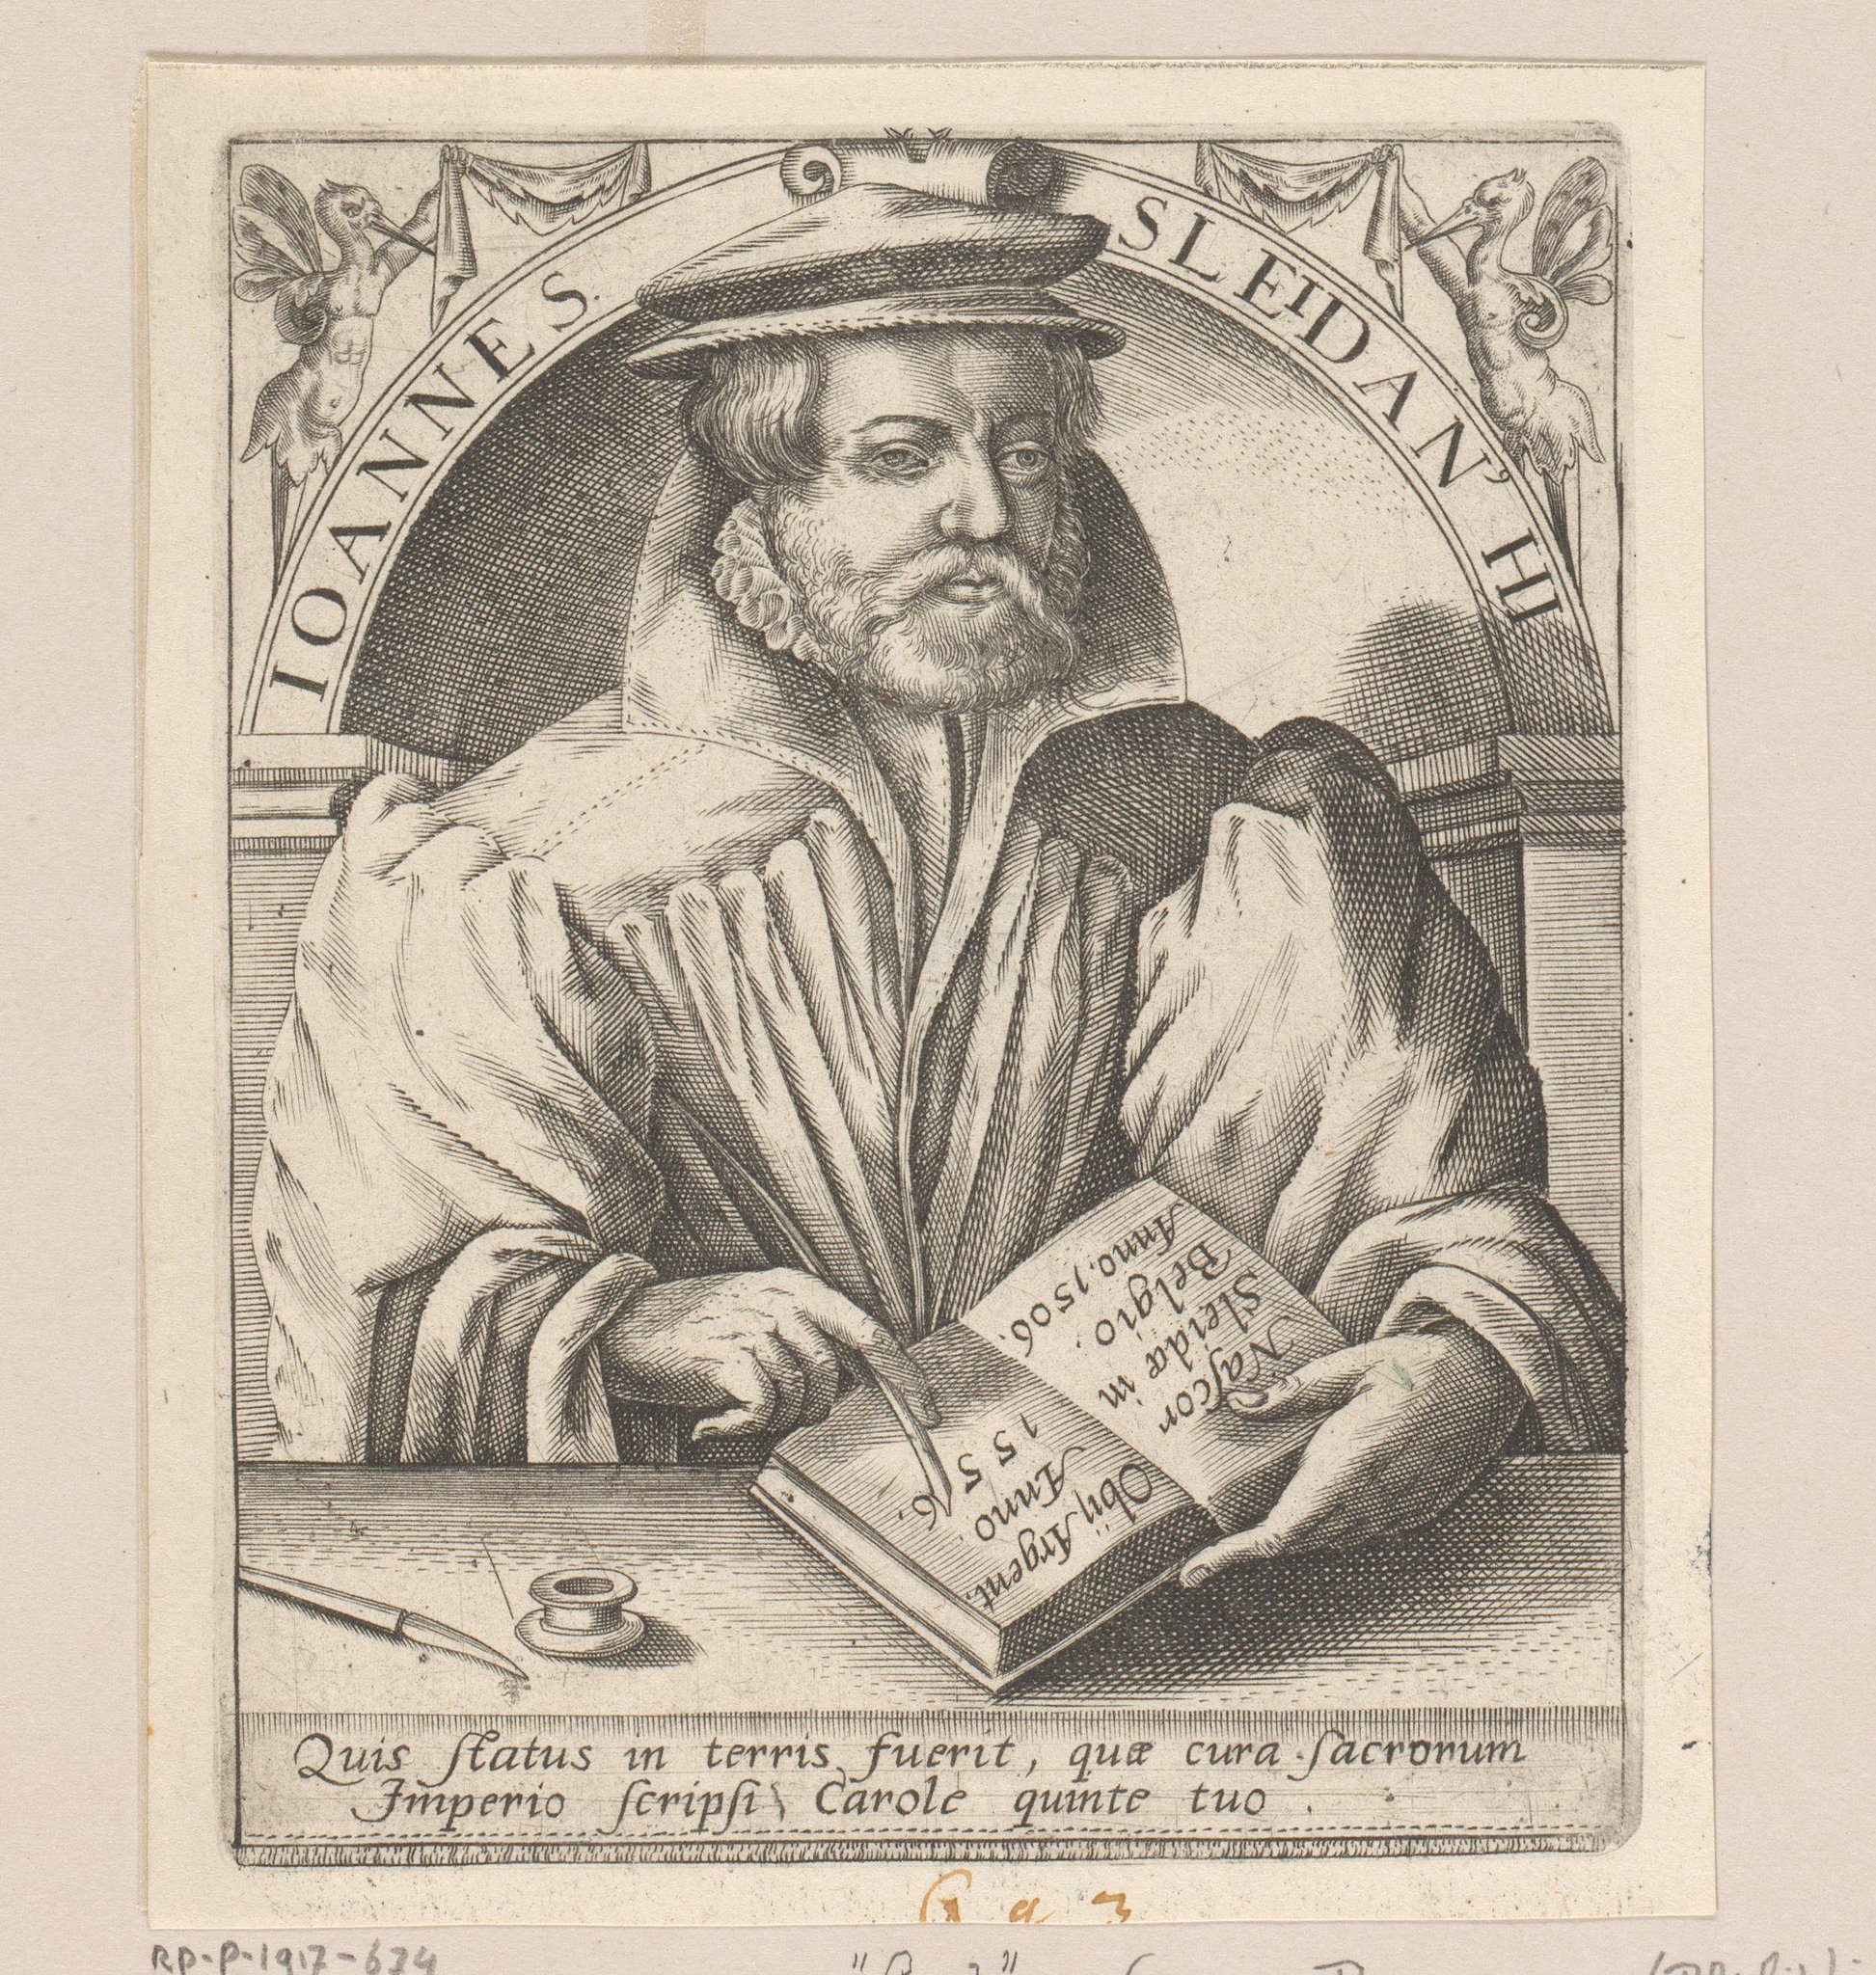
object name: book illustration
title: Ioannes Sleidan[9] HI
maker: jean jacques boissard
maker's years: 1528-1598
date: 1598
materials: paper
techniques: engraving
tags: historical persons, diplomacy, diplomat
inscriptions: collector's mark: Lugt 2228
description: Prent gebruikt in: Boissard, Jean Jacques. Icones quinquaginta virorum illustrium doctrina & eruditione praestantium ad vivum effictae. 4 dln. Frankfurt am Main: s.n., 1597-1599. Mogelijk ook gebruikt in latere edities. Latere staat van prent verschenen in: Boissard, Jean Jacques. Bibliotheca chalcographica. 8 dln. Frankfurt am Main: Johannes Ammon, 1650-1652. Ook gebruikt in latere edities.